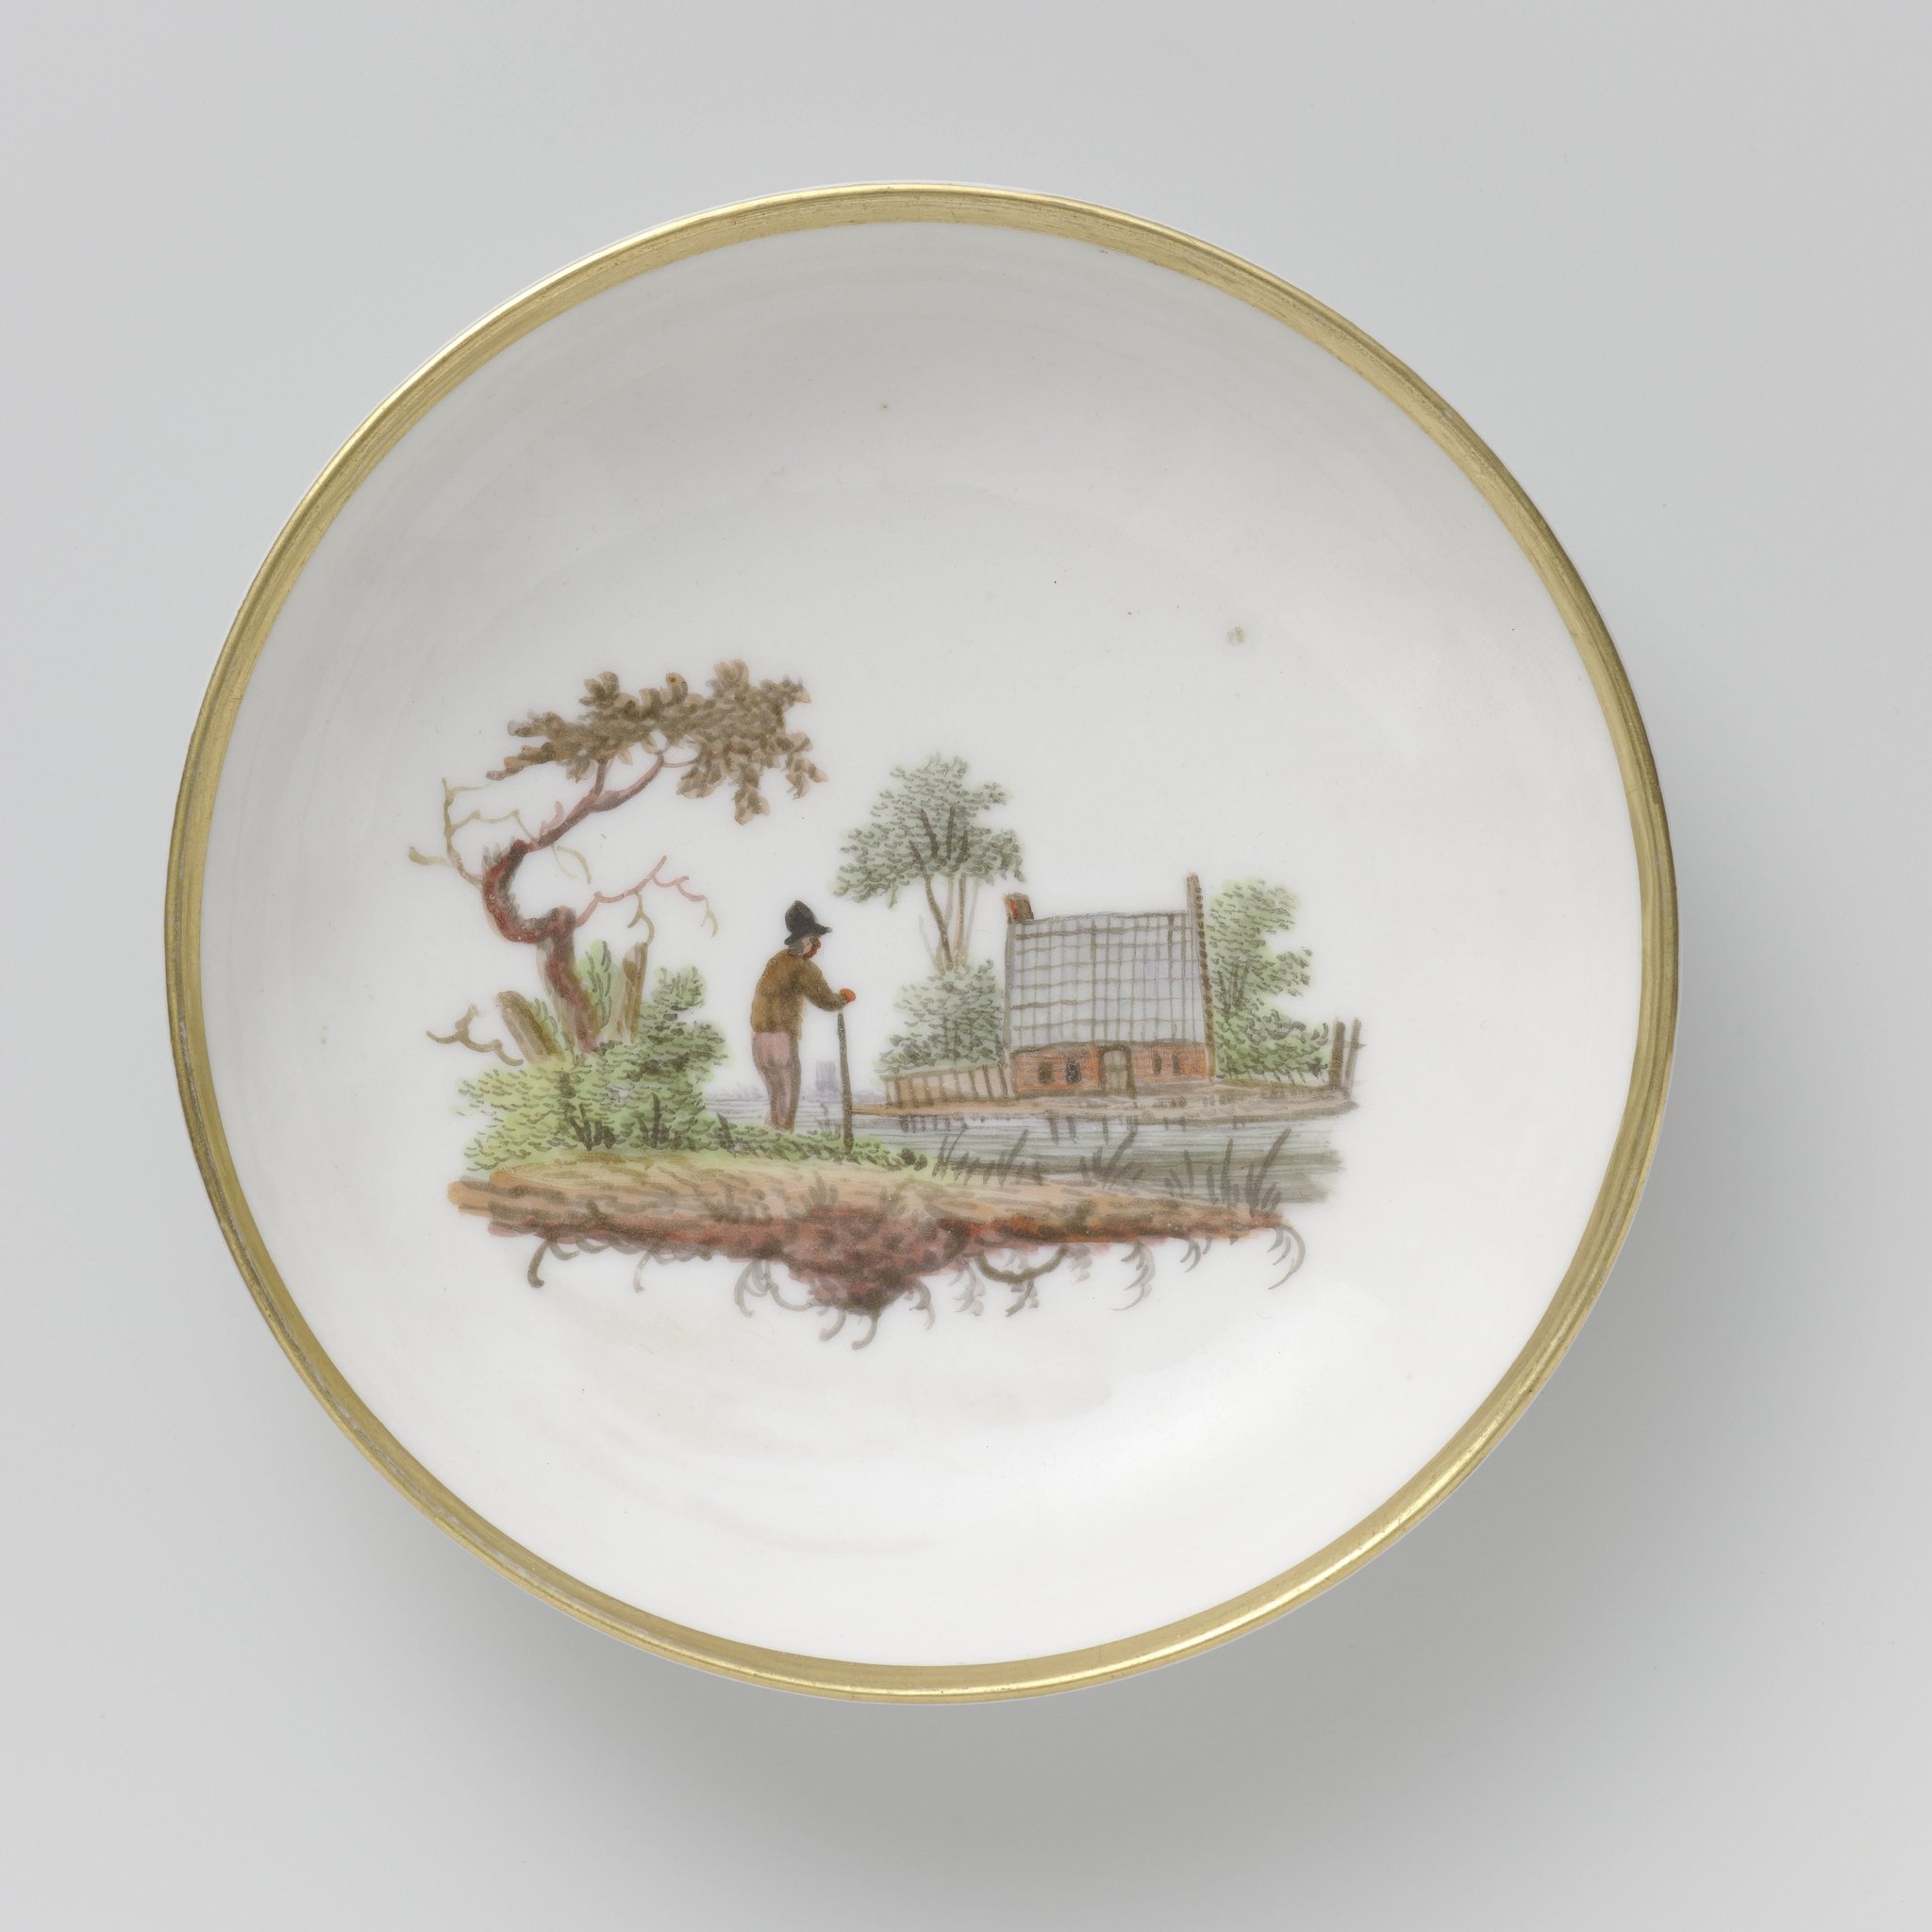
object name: kop en schotel, kop en schotel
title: Kop en schotel met riviergezicht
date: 1809-1814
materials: porcelain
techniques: painted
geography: nieuwer-amstel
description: Kop en schotel versierd met een veelkleurig landschap. Langs de randen een goude rand. Gemerkt: Amstel.